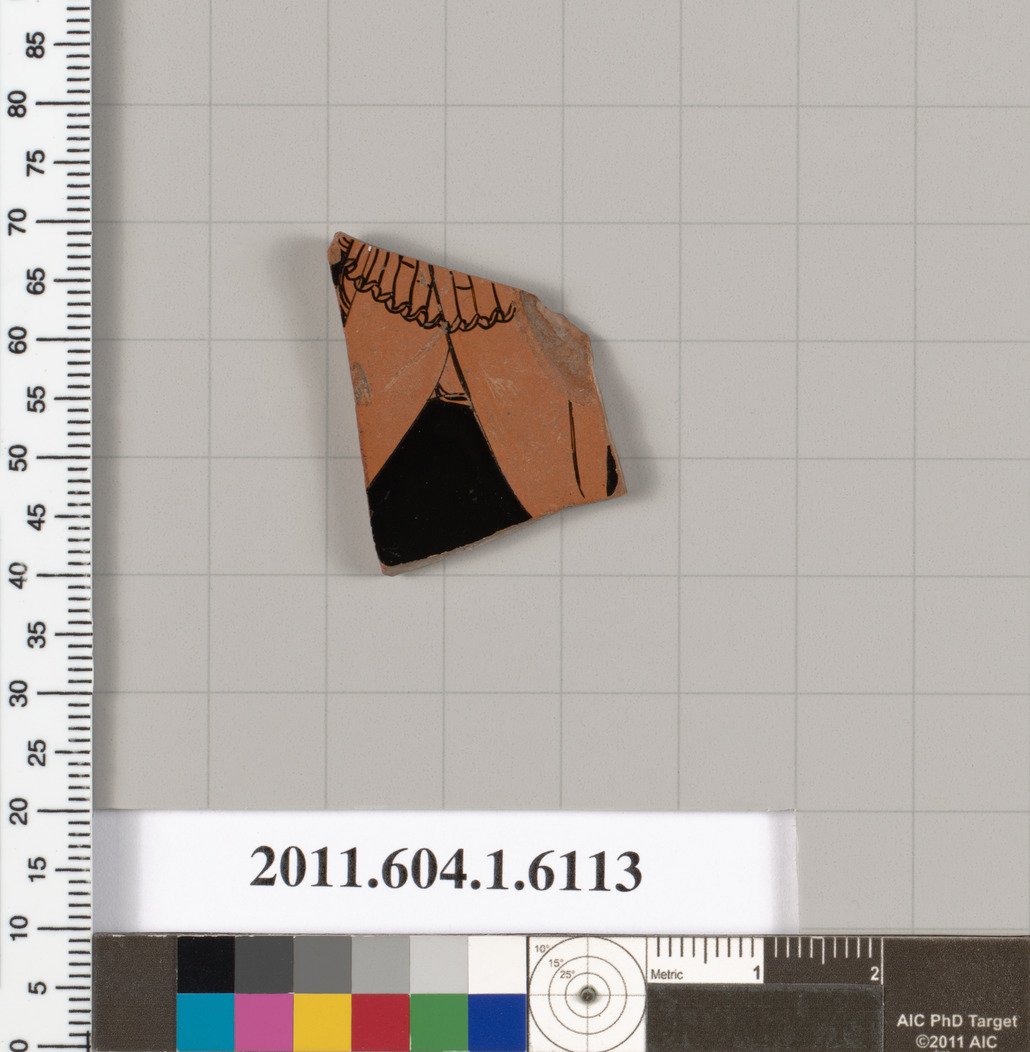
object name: kylix fragment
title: Terracotta fragment of a kylix (drinking cup)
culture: greek, attic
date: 510-490 BCE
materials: terracotta